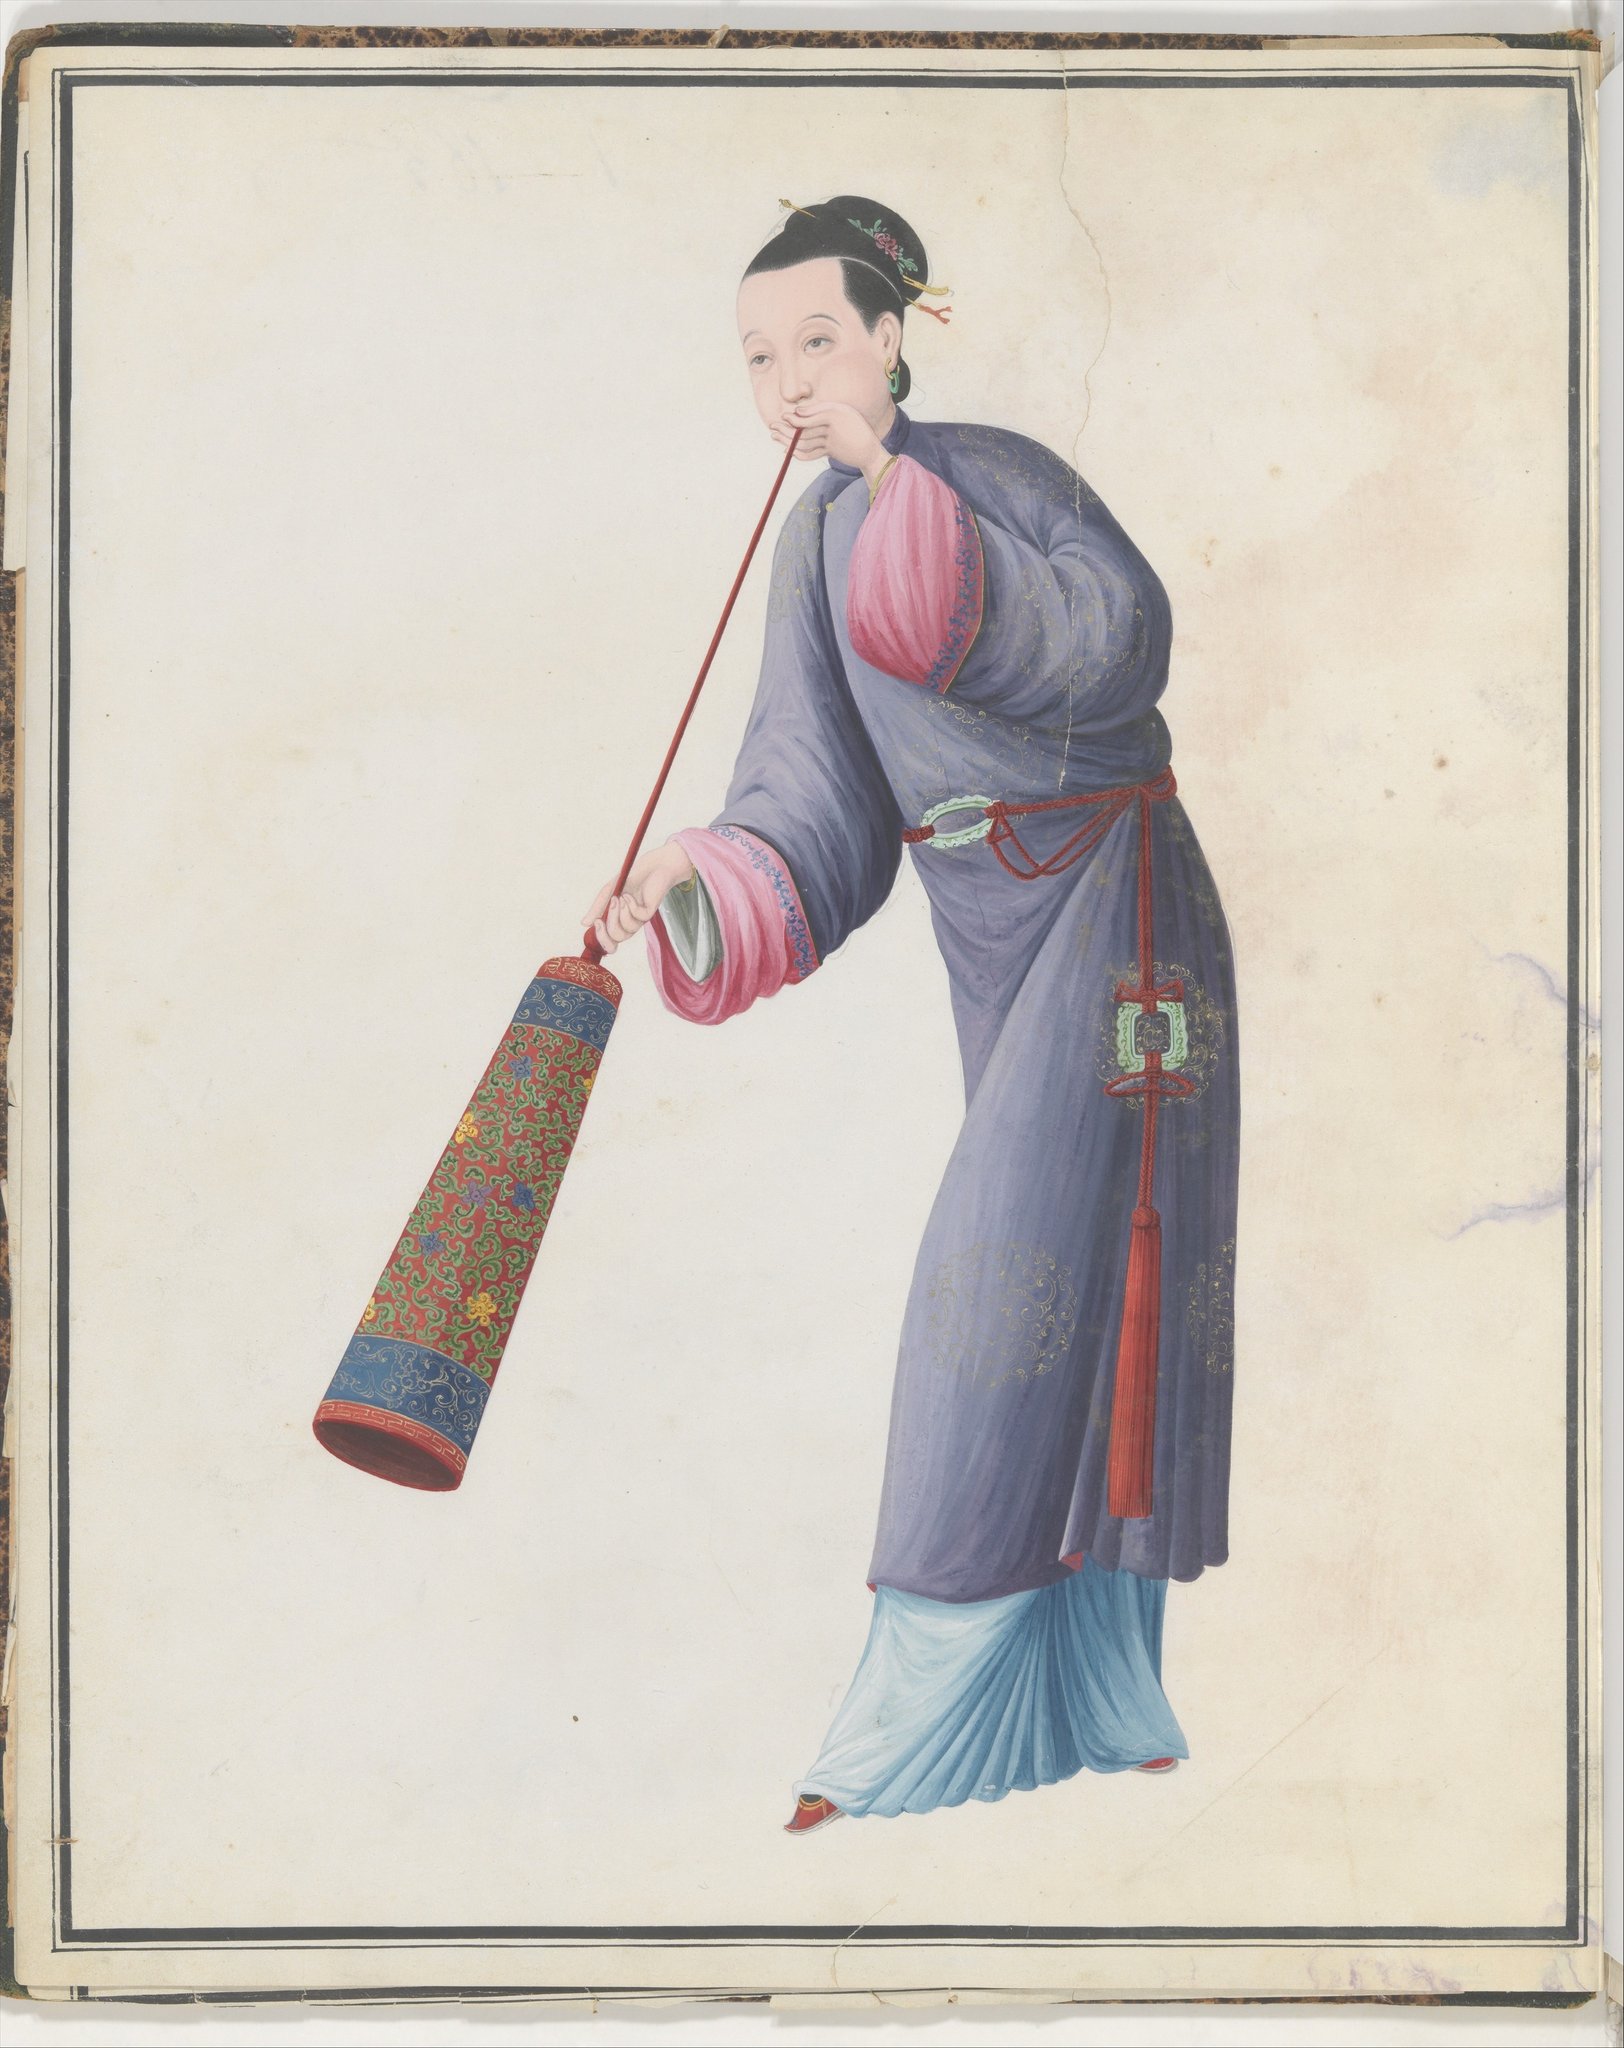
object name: watercolor of musician playing laba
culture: chinese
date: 1767-1800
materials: paper, watercolor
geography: china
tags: musical instruments,women,musicians